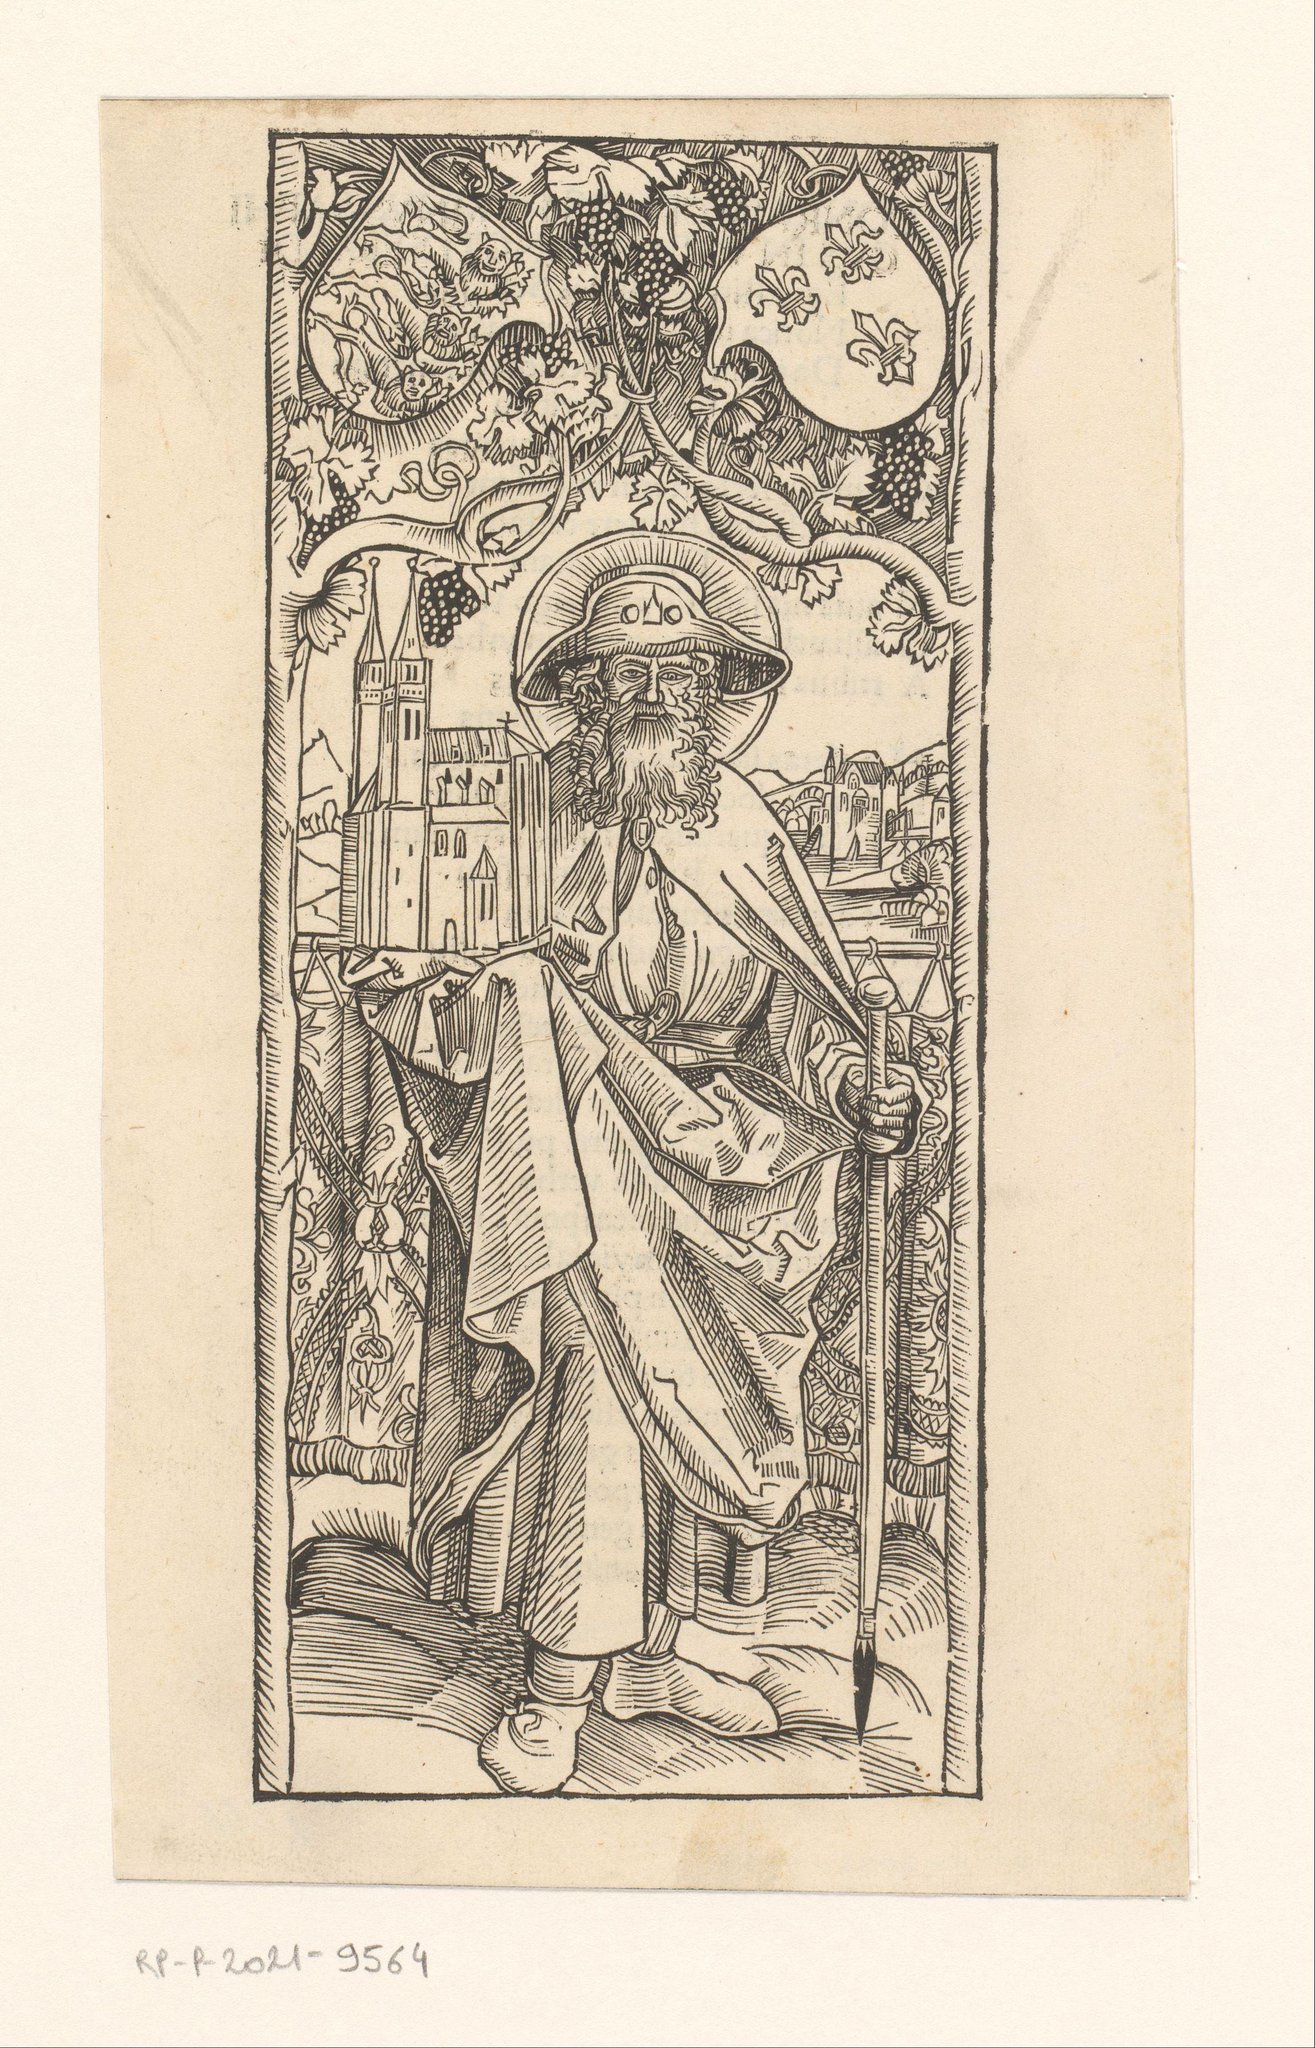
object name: book illustration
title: Heilige Sebaldus van Neurenberg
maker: Anonymous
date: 1550-1650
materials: paper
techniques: letterpress printing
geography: germany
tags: the hermit and pilgrim sebald of nuremberg; possible attributes: crown (at his feet or on book), model of church, armorial bearing, heraldry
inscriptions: number: ‘2661’, collector's mark: Lugt 2228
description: Prent komt uit een onbekende publicatie.